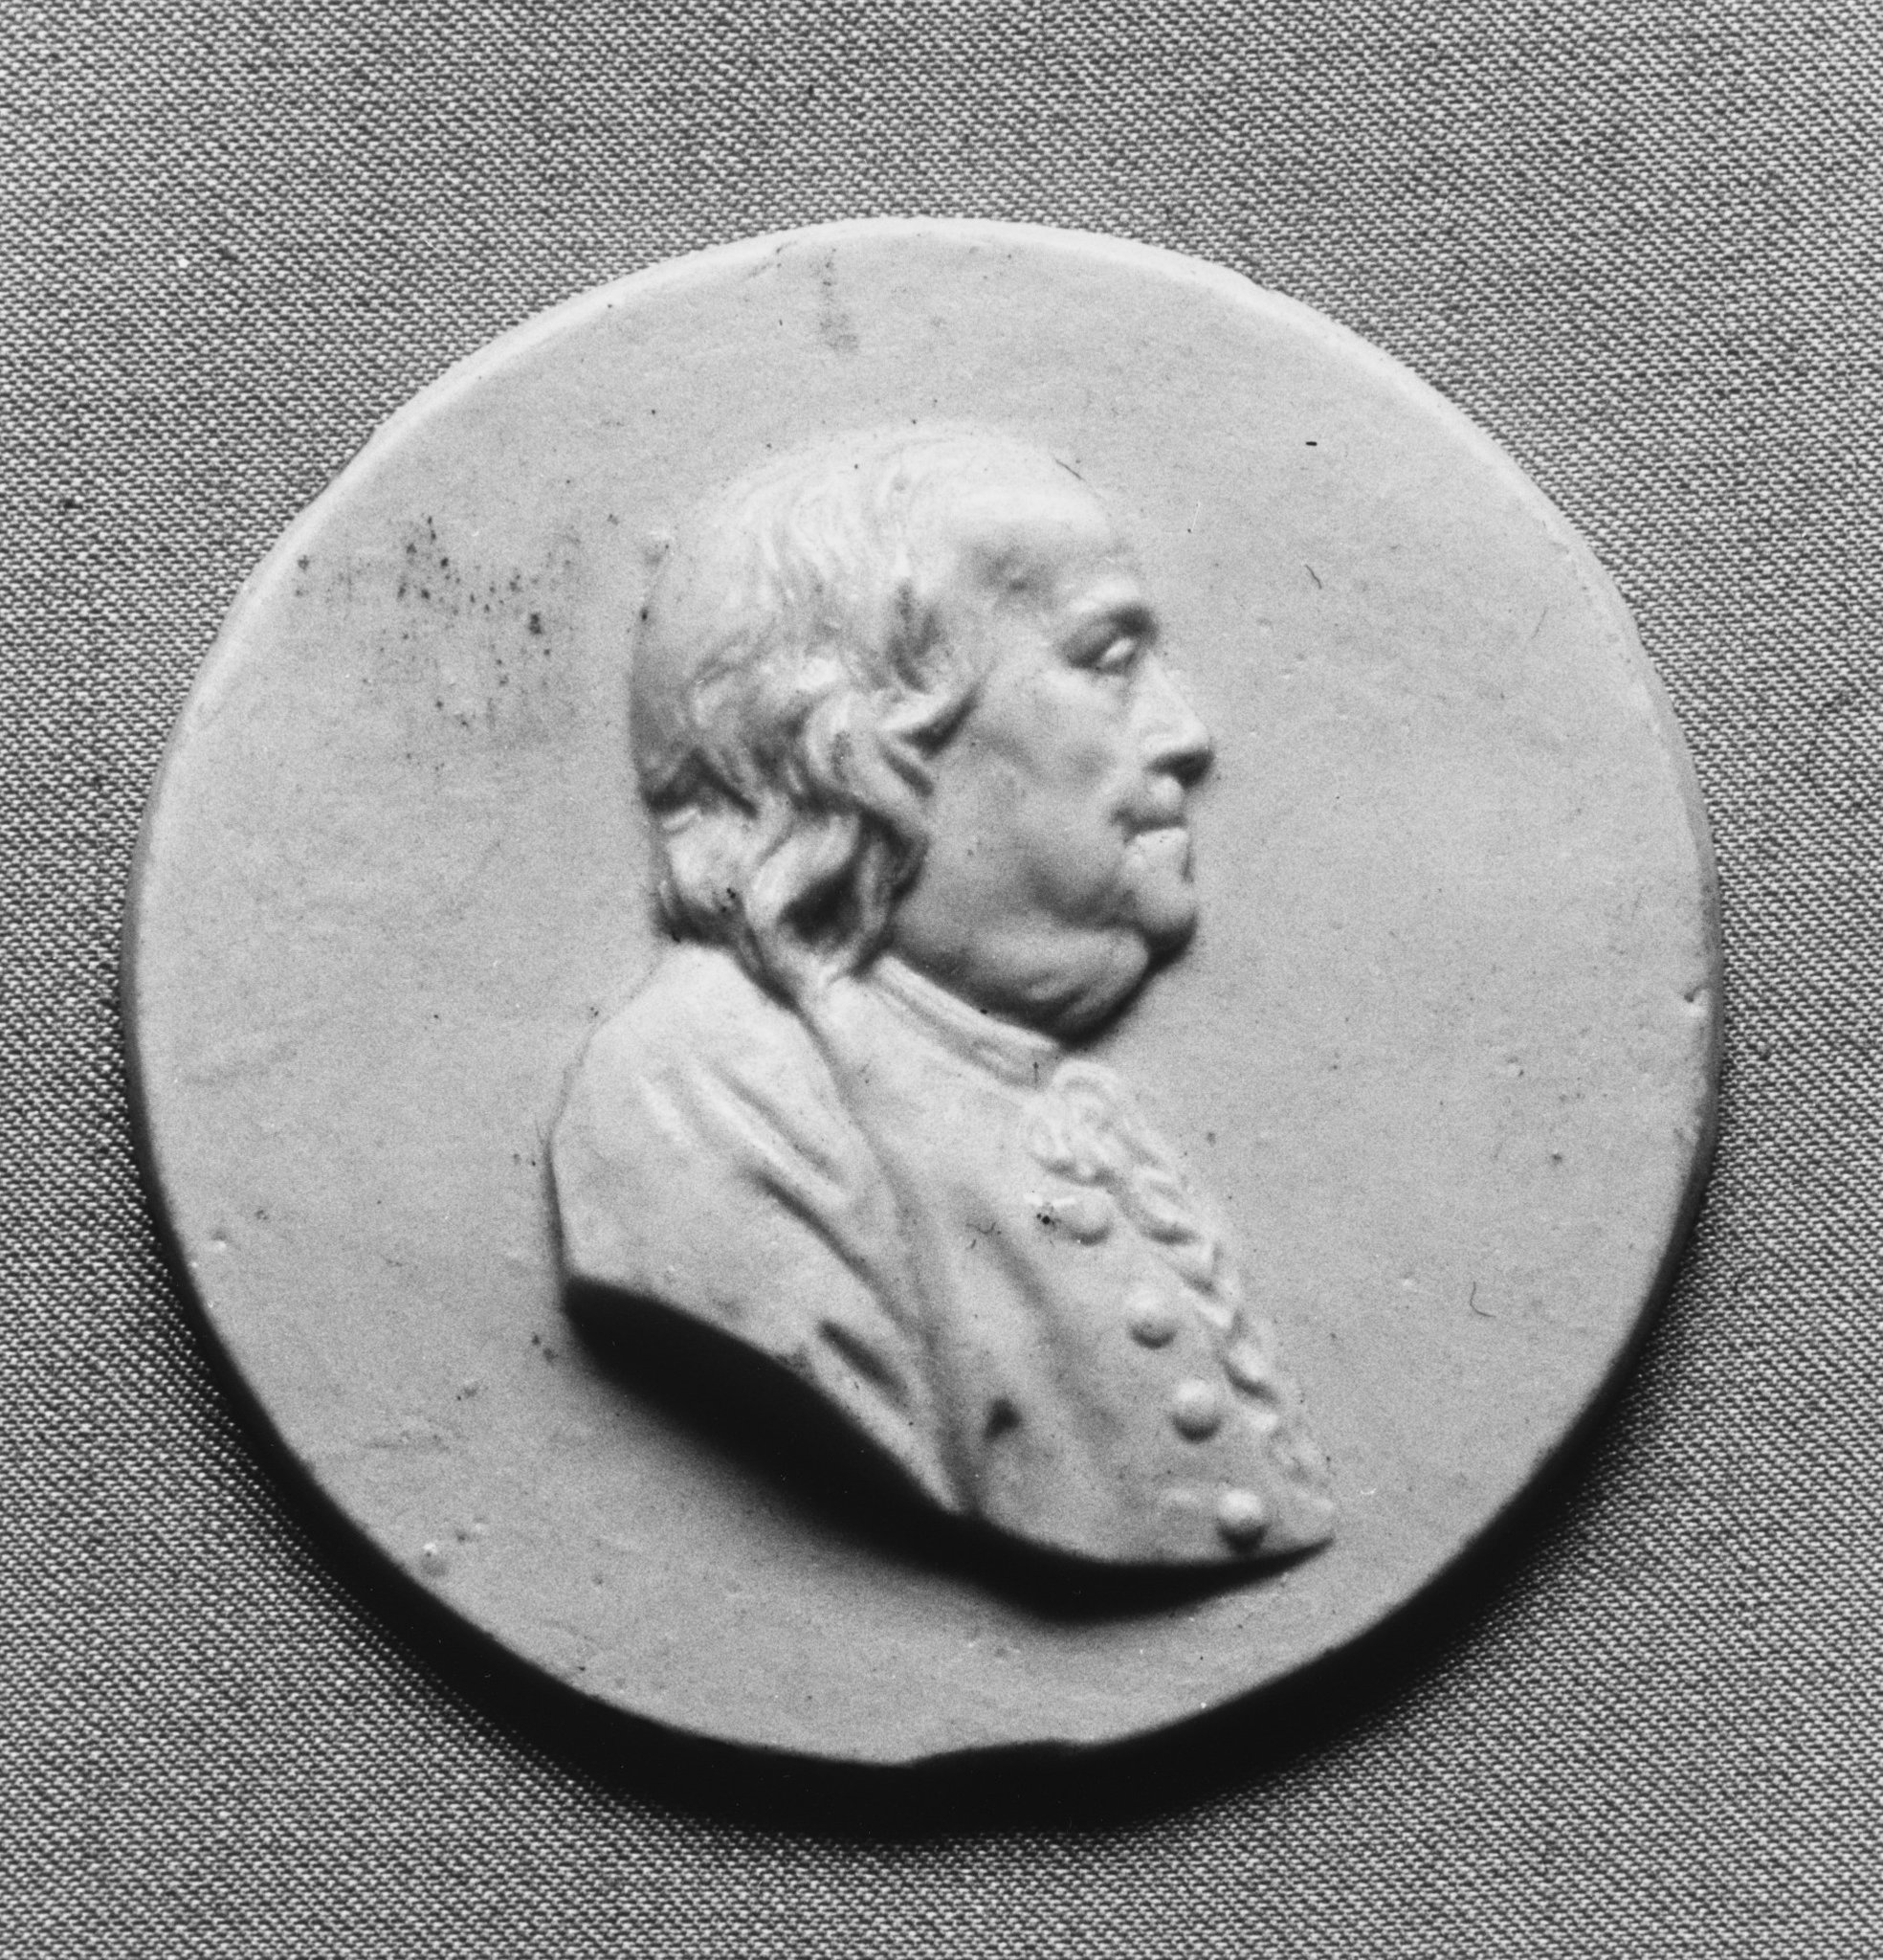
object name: plaque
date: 1800-1883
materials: glass, paste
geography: france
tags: men,profiles